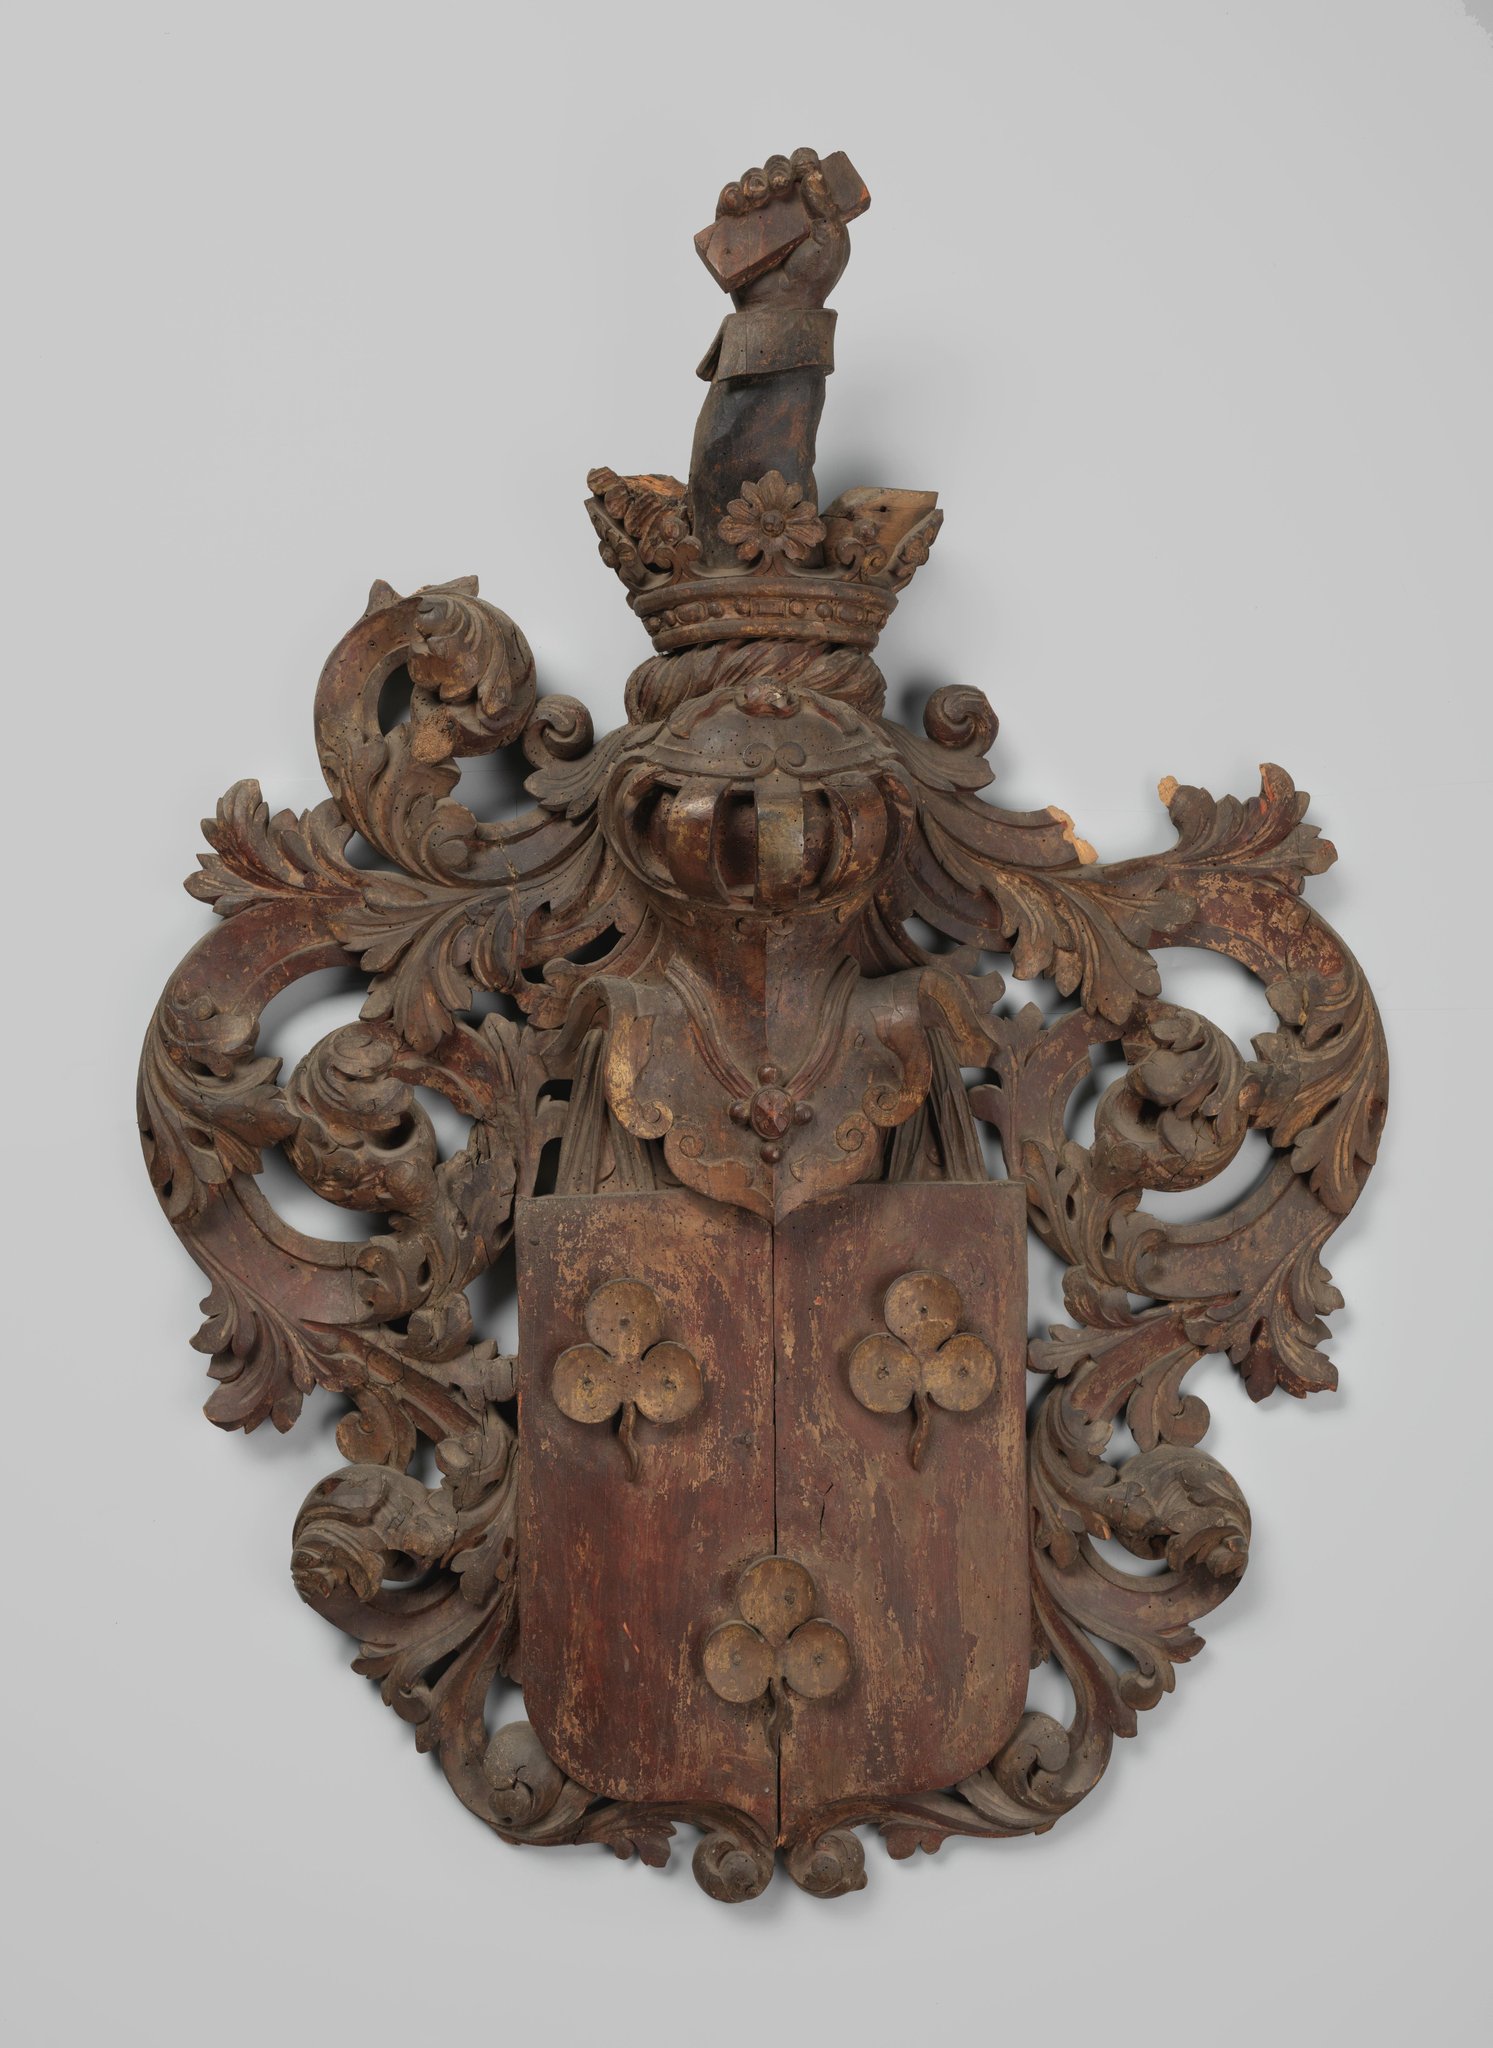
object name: wapenbord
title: Houten wapenbord met in het wapen drie klaverbladen, afkomstig van de familie Hopman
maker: Anonymous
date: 1650-1800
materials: wood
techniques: cutting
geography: overijssel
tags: overijssel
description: Houten gepolychromeerd wapenbord. Het wapen wordt gedekt door een helm en heeft dekkleden. Het wapen draagt drie klaverbladen (twee boven, éen onder). Het helmteken bestaat uit een vuist die een blokje omklemt. De kleuren zijn grotendeels afgesleten.